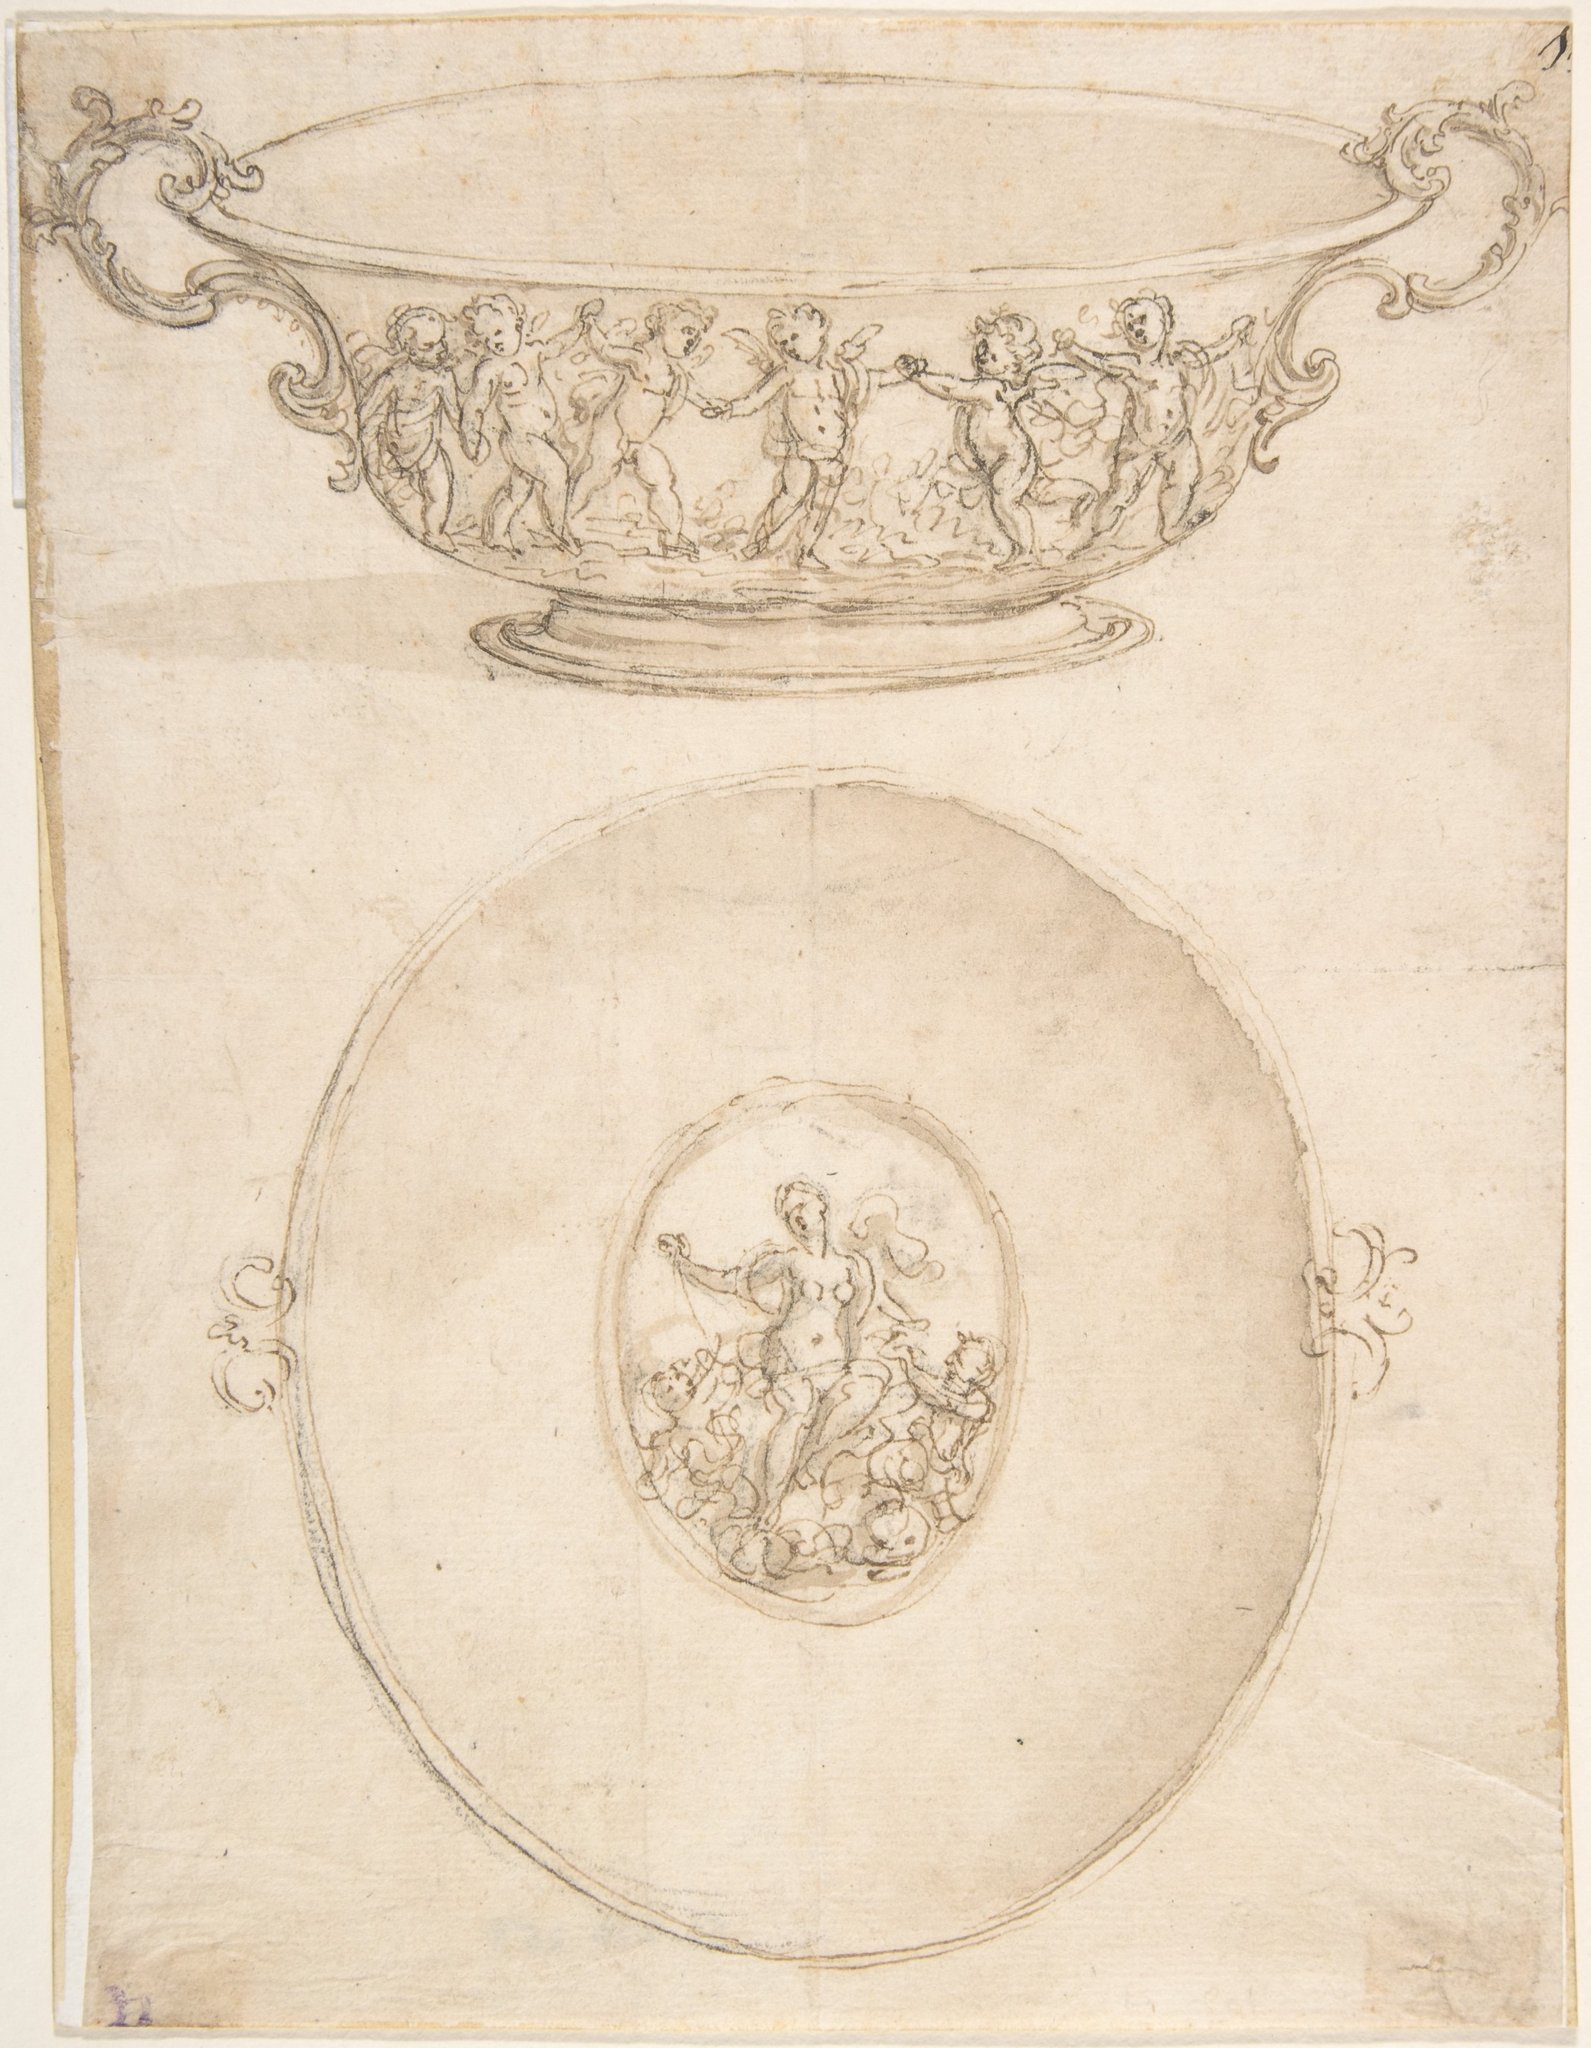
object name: drawing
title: Two Views of a Design for a Shallow (Drinking?) Bowl wih Handles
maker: giovanni battista foggini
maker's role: artist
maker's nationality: italian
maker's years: 1652-1725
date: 1672-1725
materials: chalk, ink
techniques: brush, pen, wash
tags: bowls